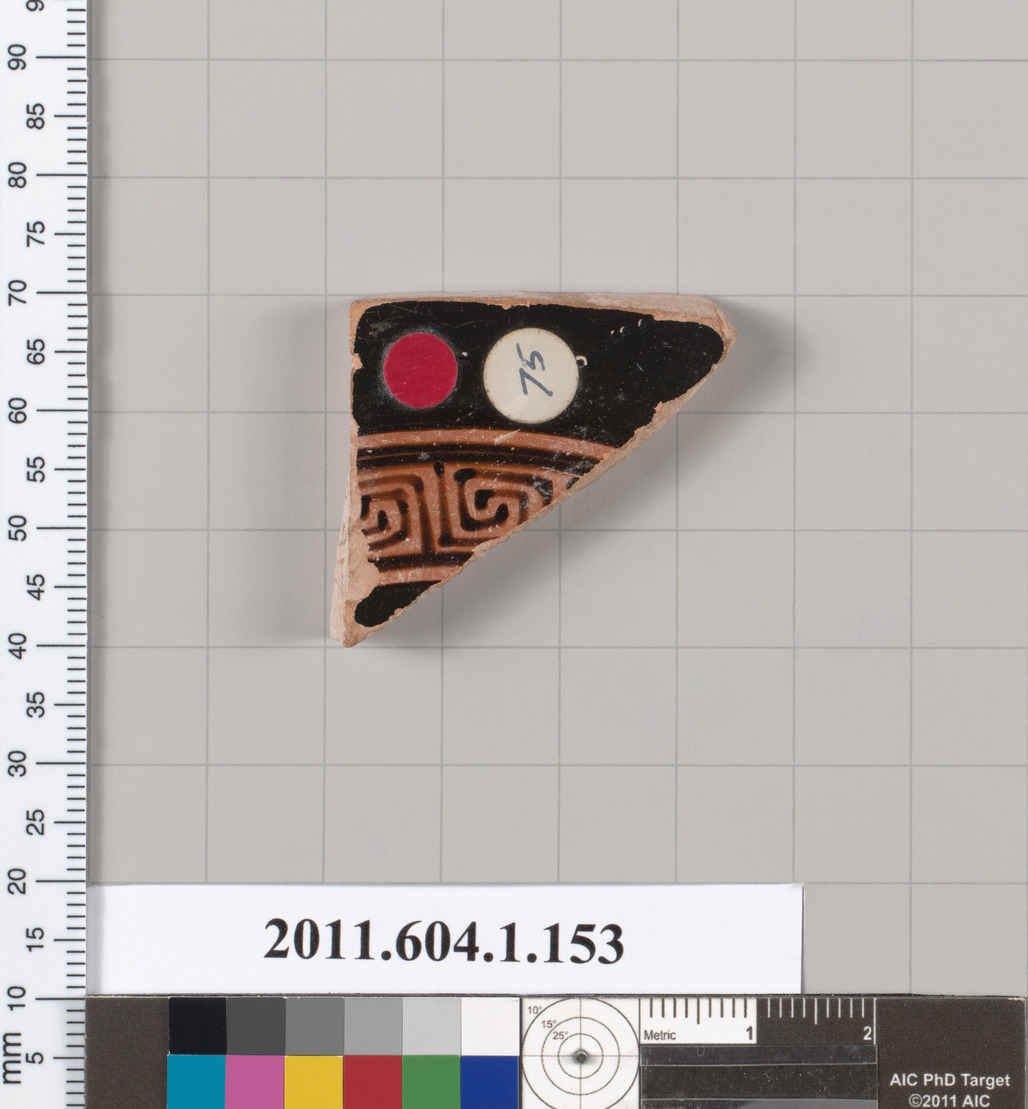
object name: kylix fragment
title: Terracotta fragment of a kylix (drinking cup)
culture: greek, attic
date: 475-451 BCE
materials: terracotta